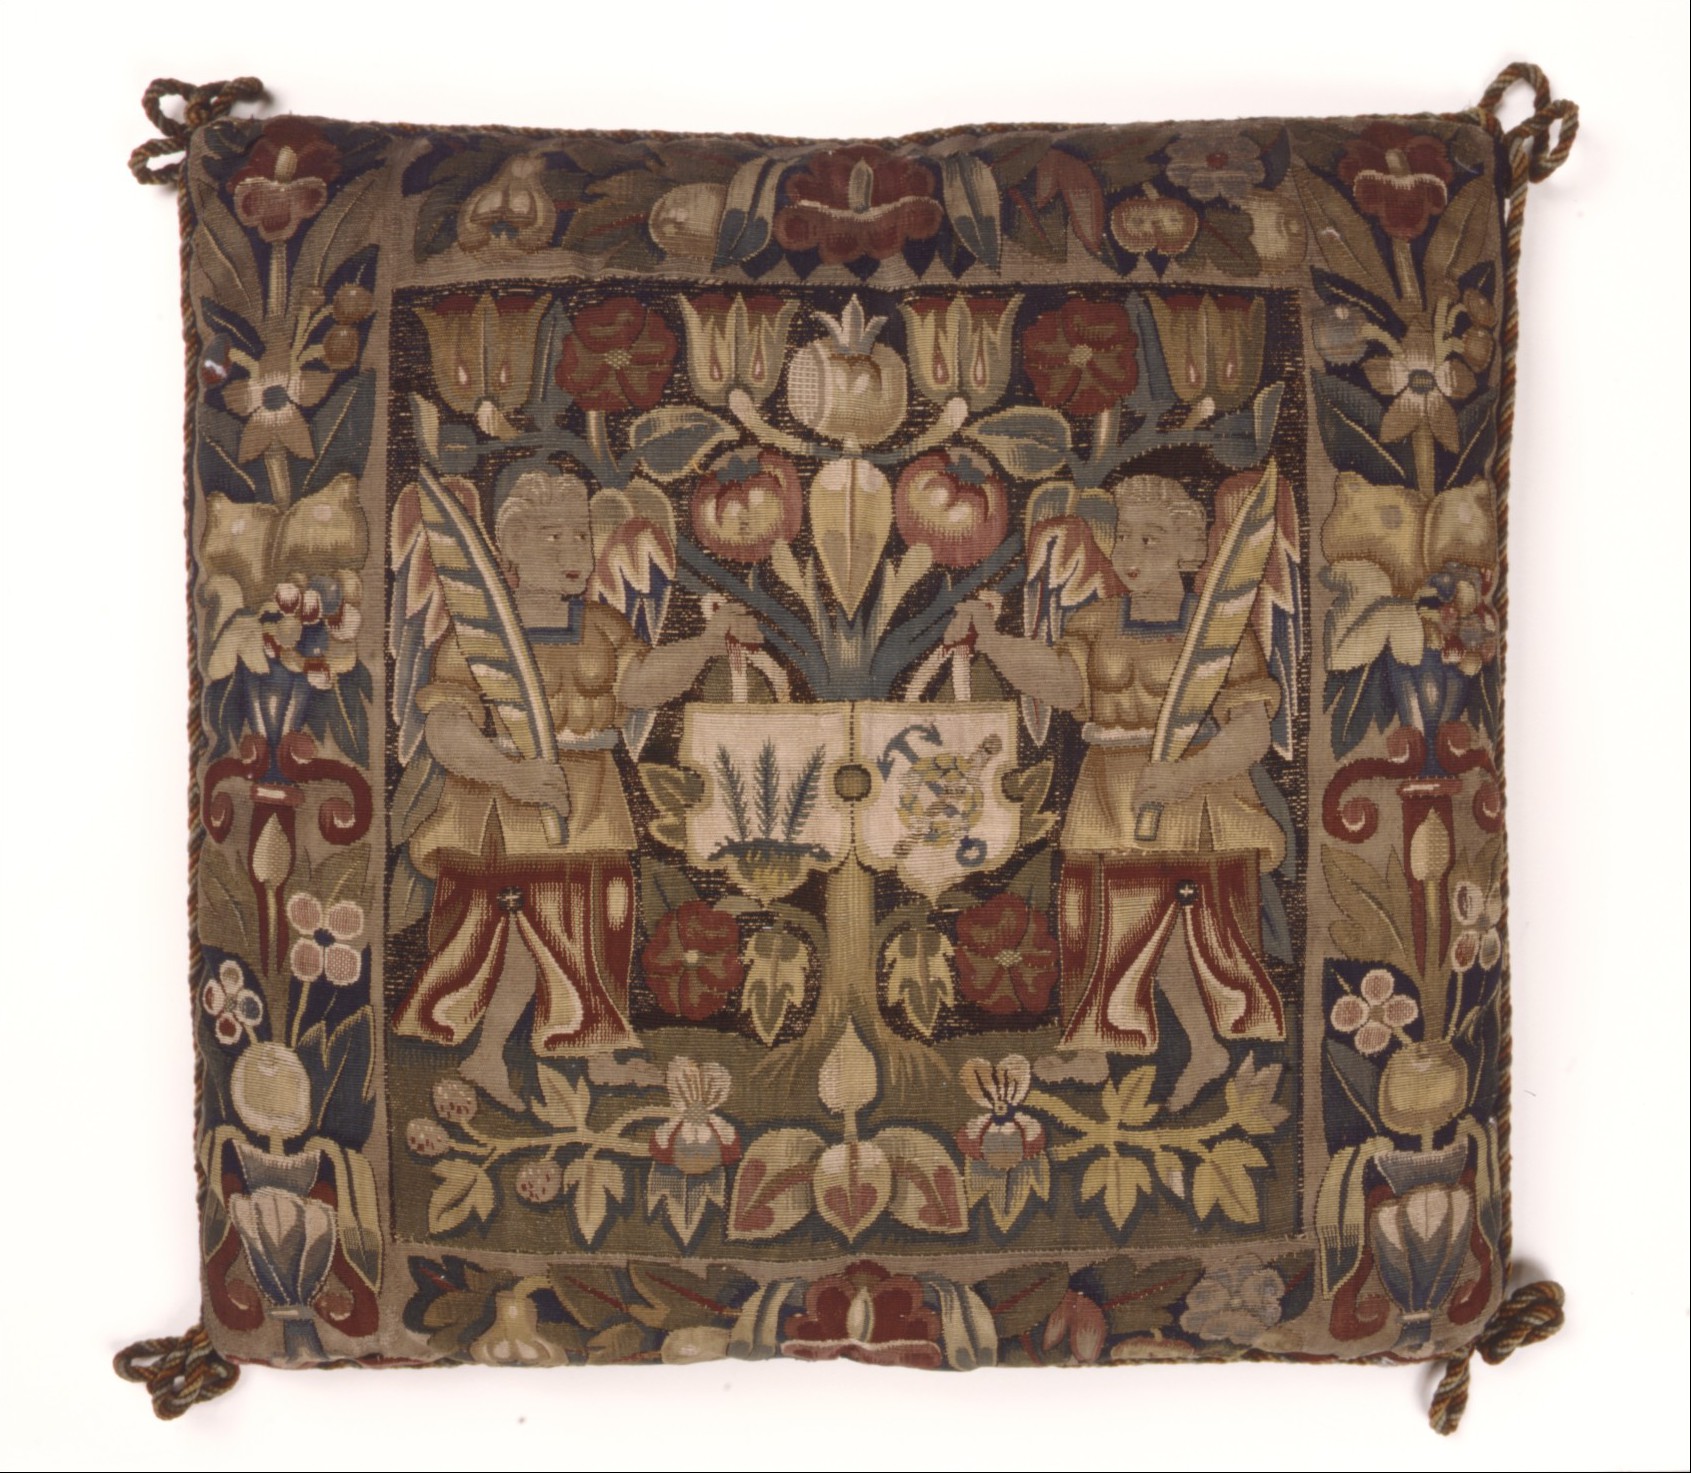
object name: cushion cover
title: Cushion Cover with Coats of Arms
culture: northern german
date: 1600-1650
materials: cord, cotton, linen, silk, wool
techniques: tapestry weave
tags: flowers,angels,coat of arms